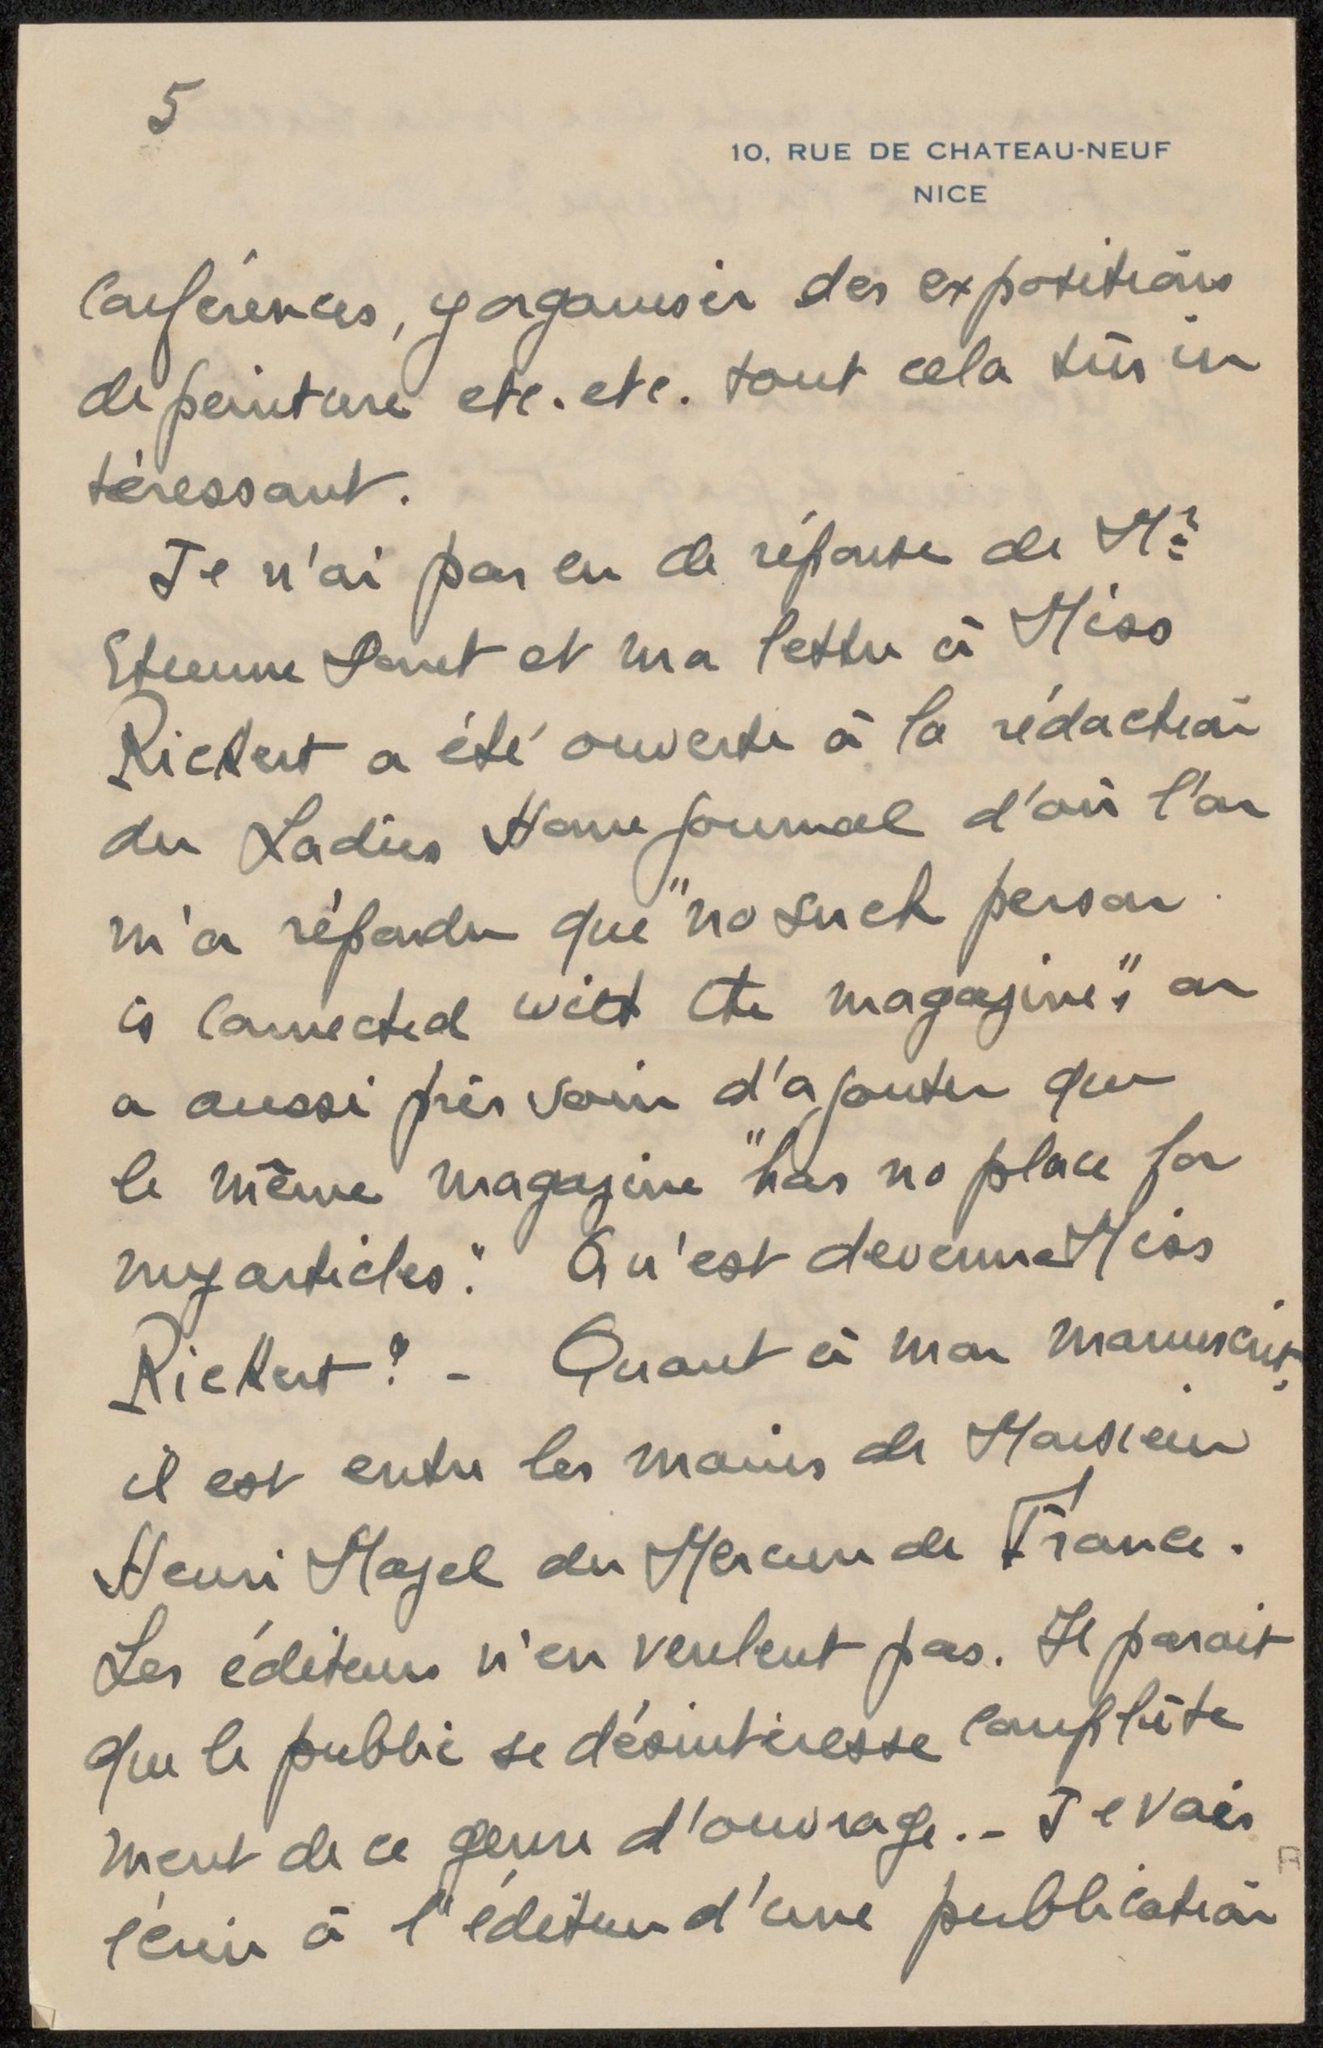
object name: letter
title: Brief aan Philip Zilcken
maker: jeanne erlich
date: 1921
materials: ink, paper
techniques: pen, printing, writing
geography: nice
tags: print maker, james abbott mcneill whistler, the hague, draughtsman, philip zilcken, literature ~ arts, temporary exhibition, 'salon', printed matter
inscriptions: collector's mark: ‘RPK’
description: Vormt samen met RP-D-1982-43-ERLICH(JEANNE)-14A een doorlopende brief.